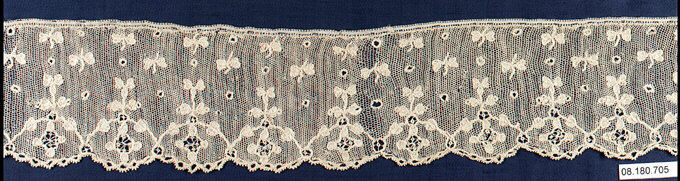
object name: fragment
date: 1701-1800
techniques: lace